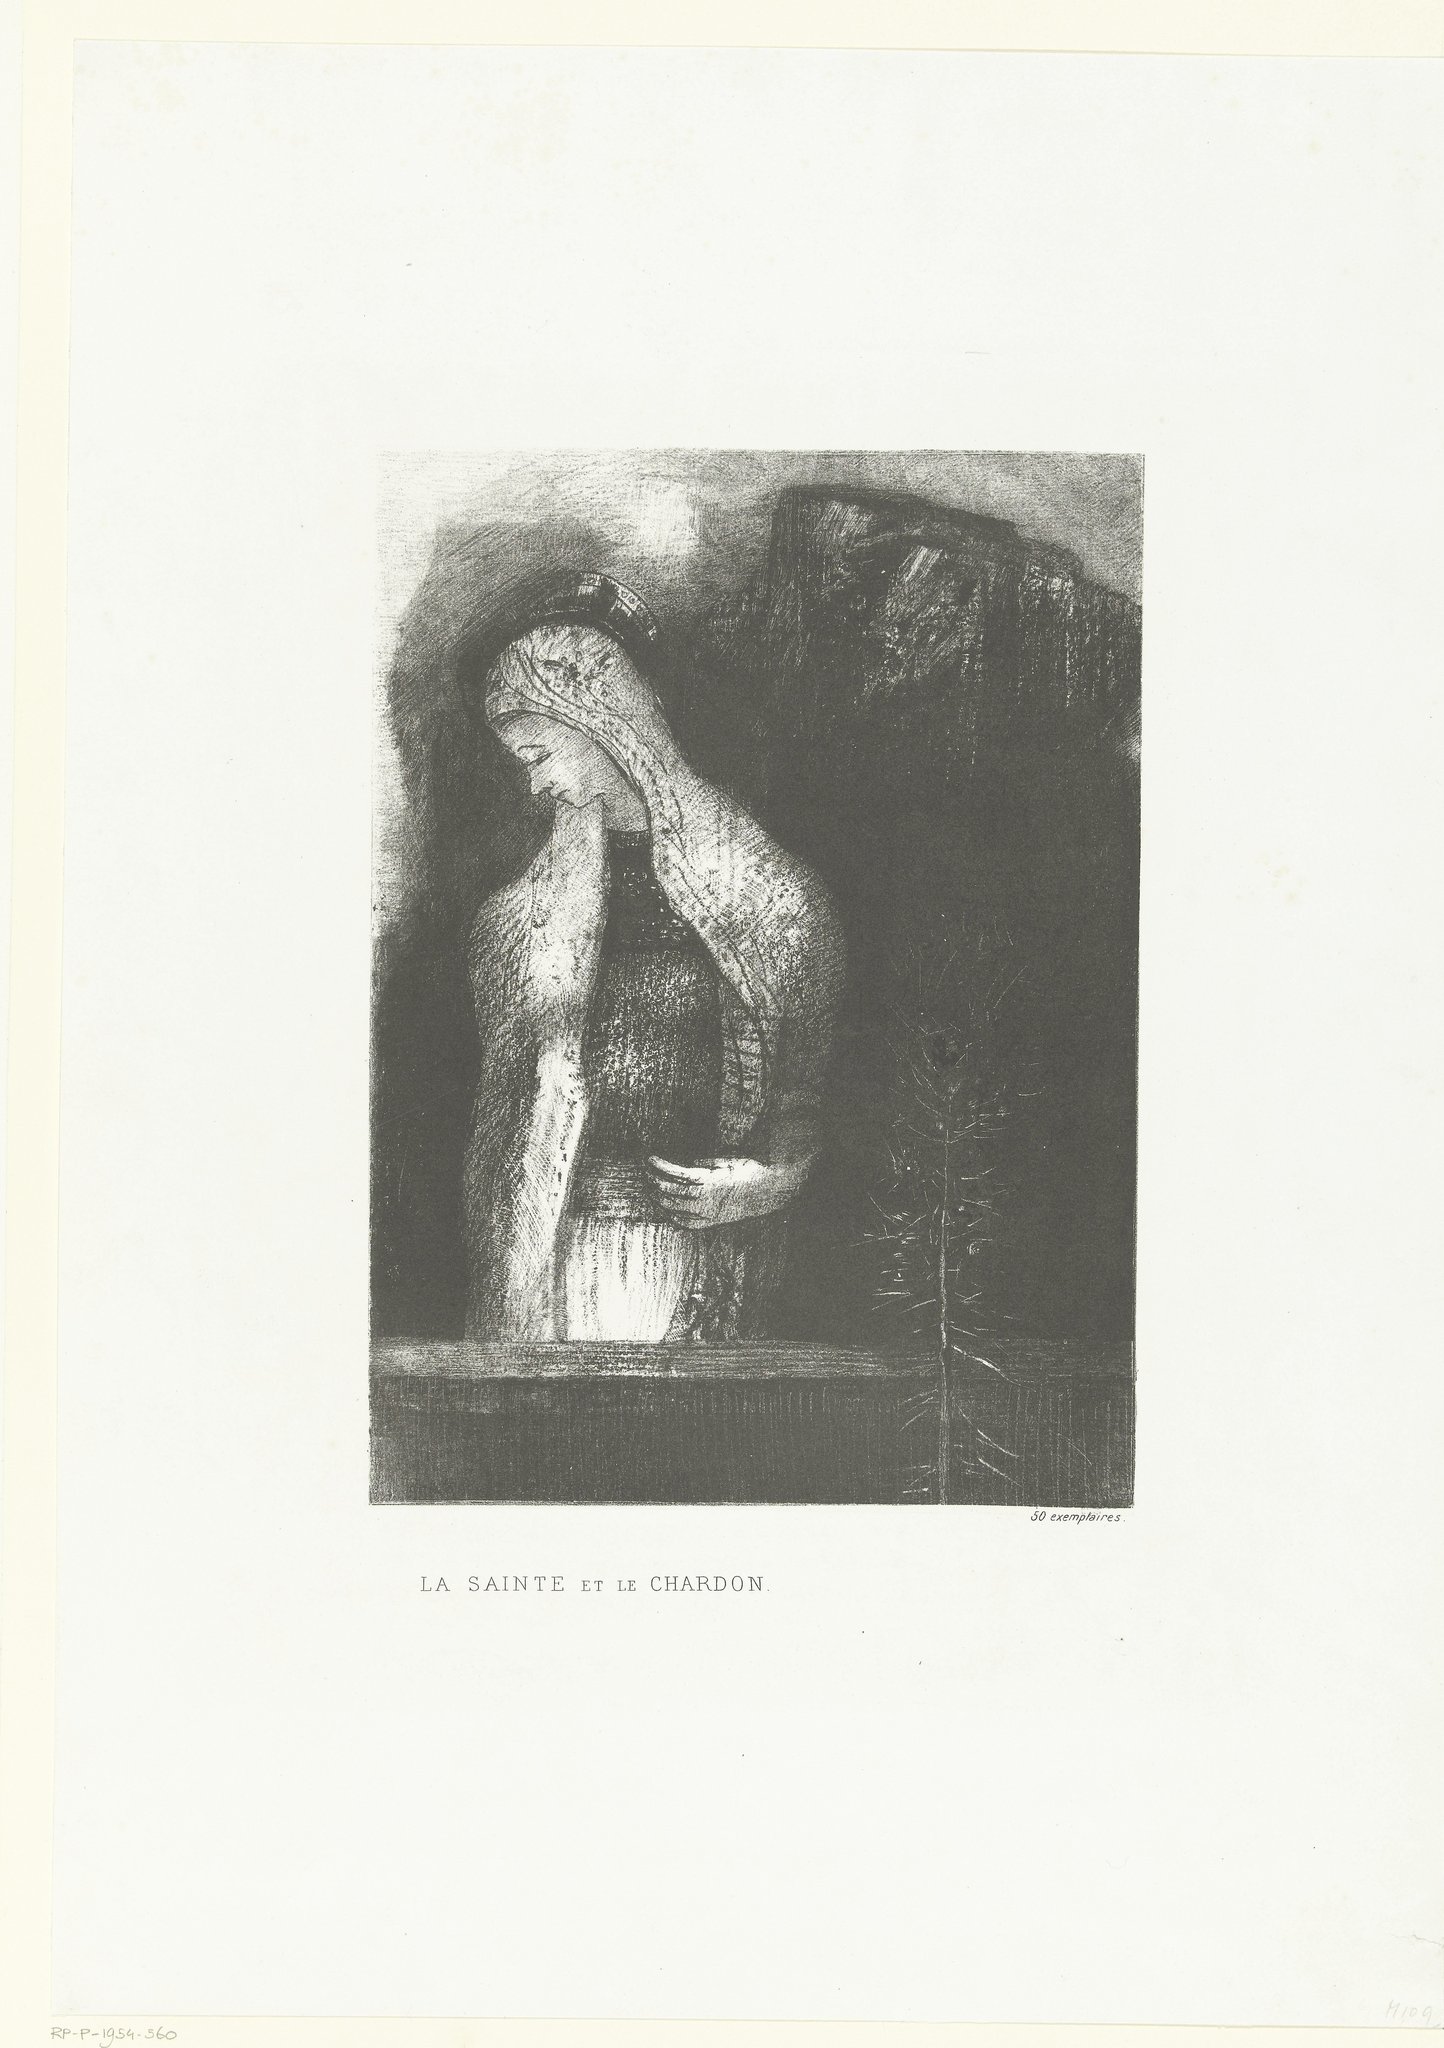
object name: print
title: De heilige en de distel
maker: odilon redon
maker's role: draughtsman, painter, print maker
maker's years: 1840-1916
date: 1891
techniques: printmaking, lithograph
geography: paris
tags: female saints, plants and herbs: thistle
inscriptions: collector's mark: Lugt 2228, collector's mark: Lugt 2760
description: Een heilige vrouw staand achter een muurtje, kijkend naar links. Rechts vóór de muur een distel.